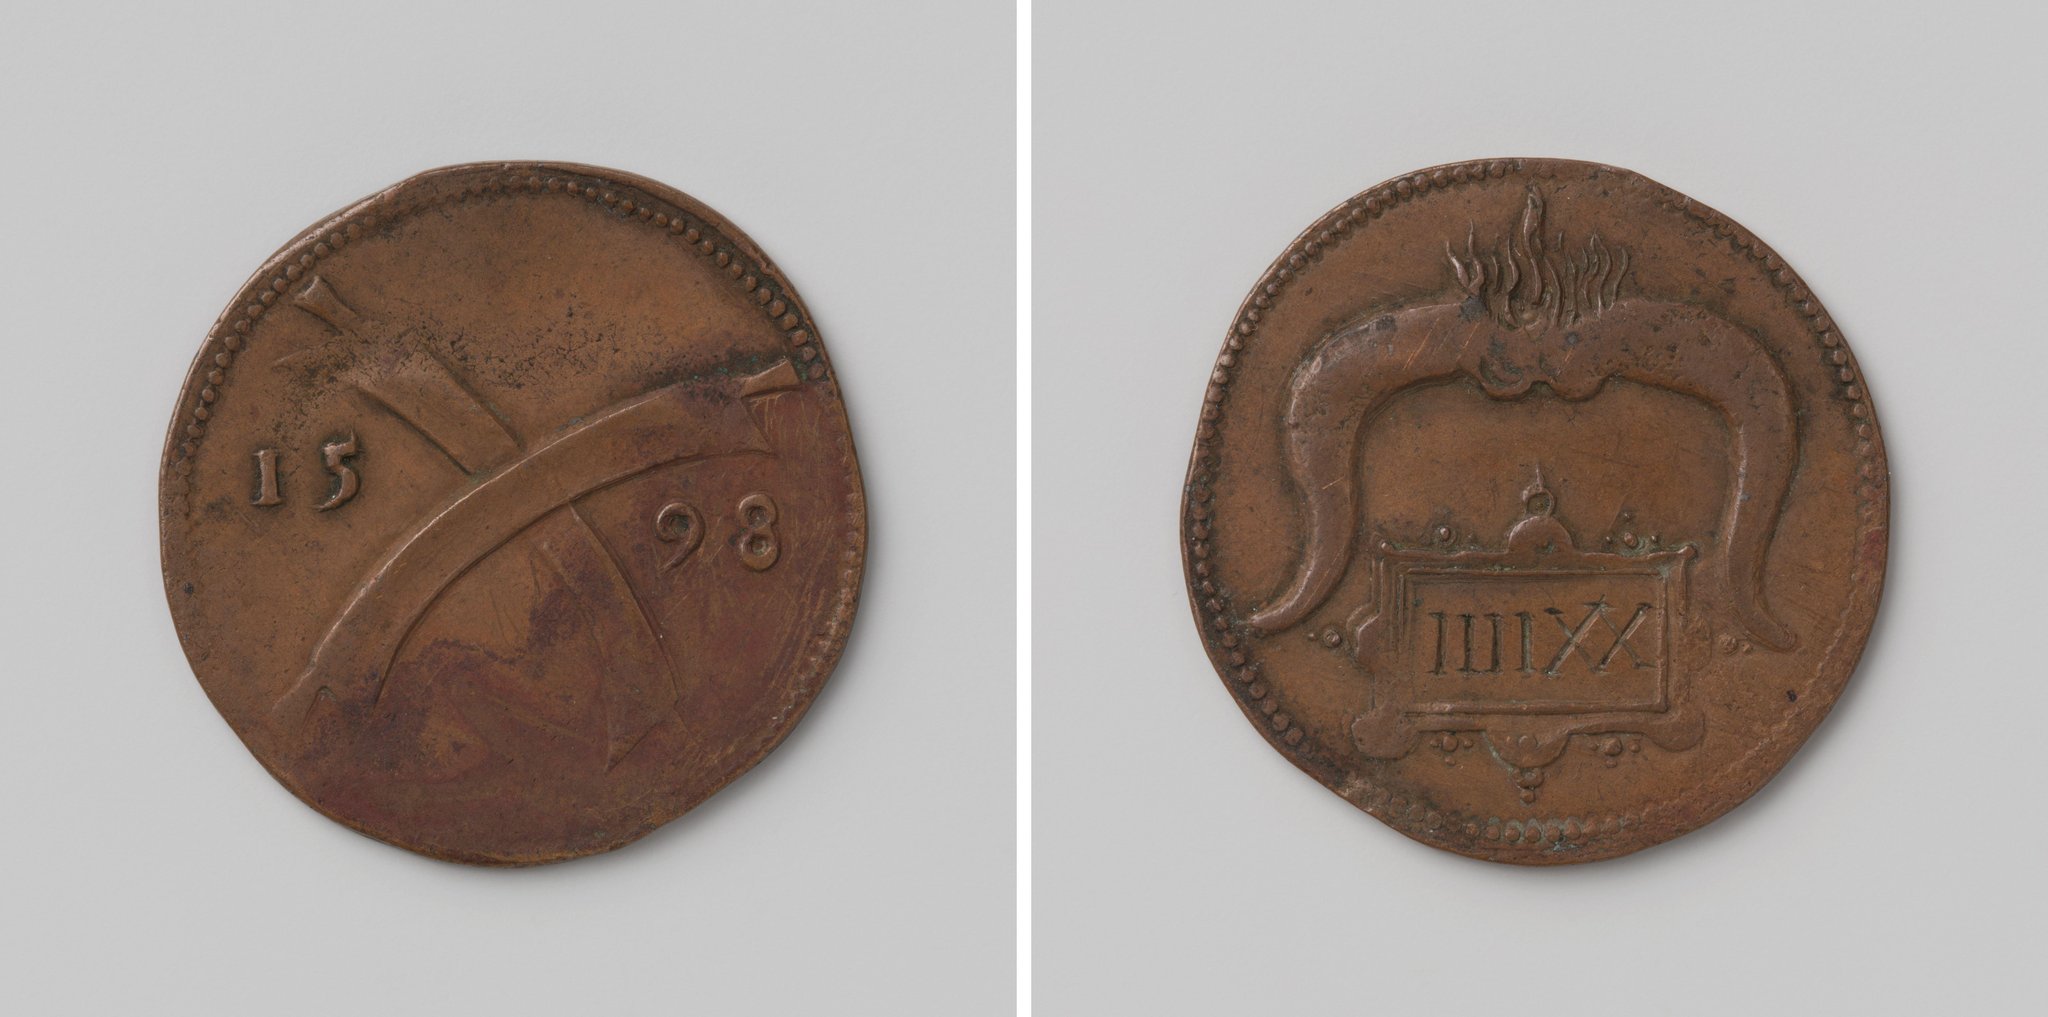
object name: medal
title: Vellenblotersgilde van Middelburg, gildepenning met no. 24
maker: Anonymous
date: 1598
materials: copper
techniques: engraving, striking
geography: middelburg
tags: middelburg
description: Koperen penning. Voorzijde: twee gekruiste messen; daartussen jaartal. Keerzijde: tableau in cartouche met cijfer XXIIII boven twee hoorns.